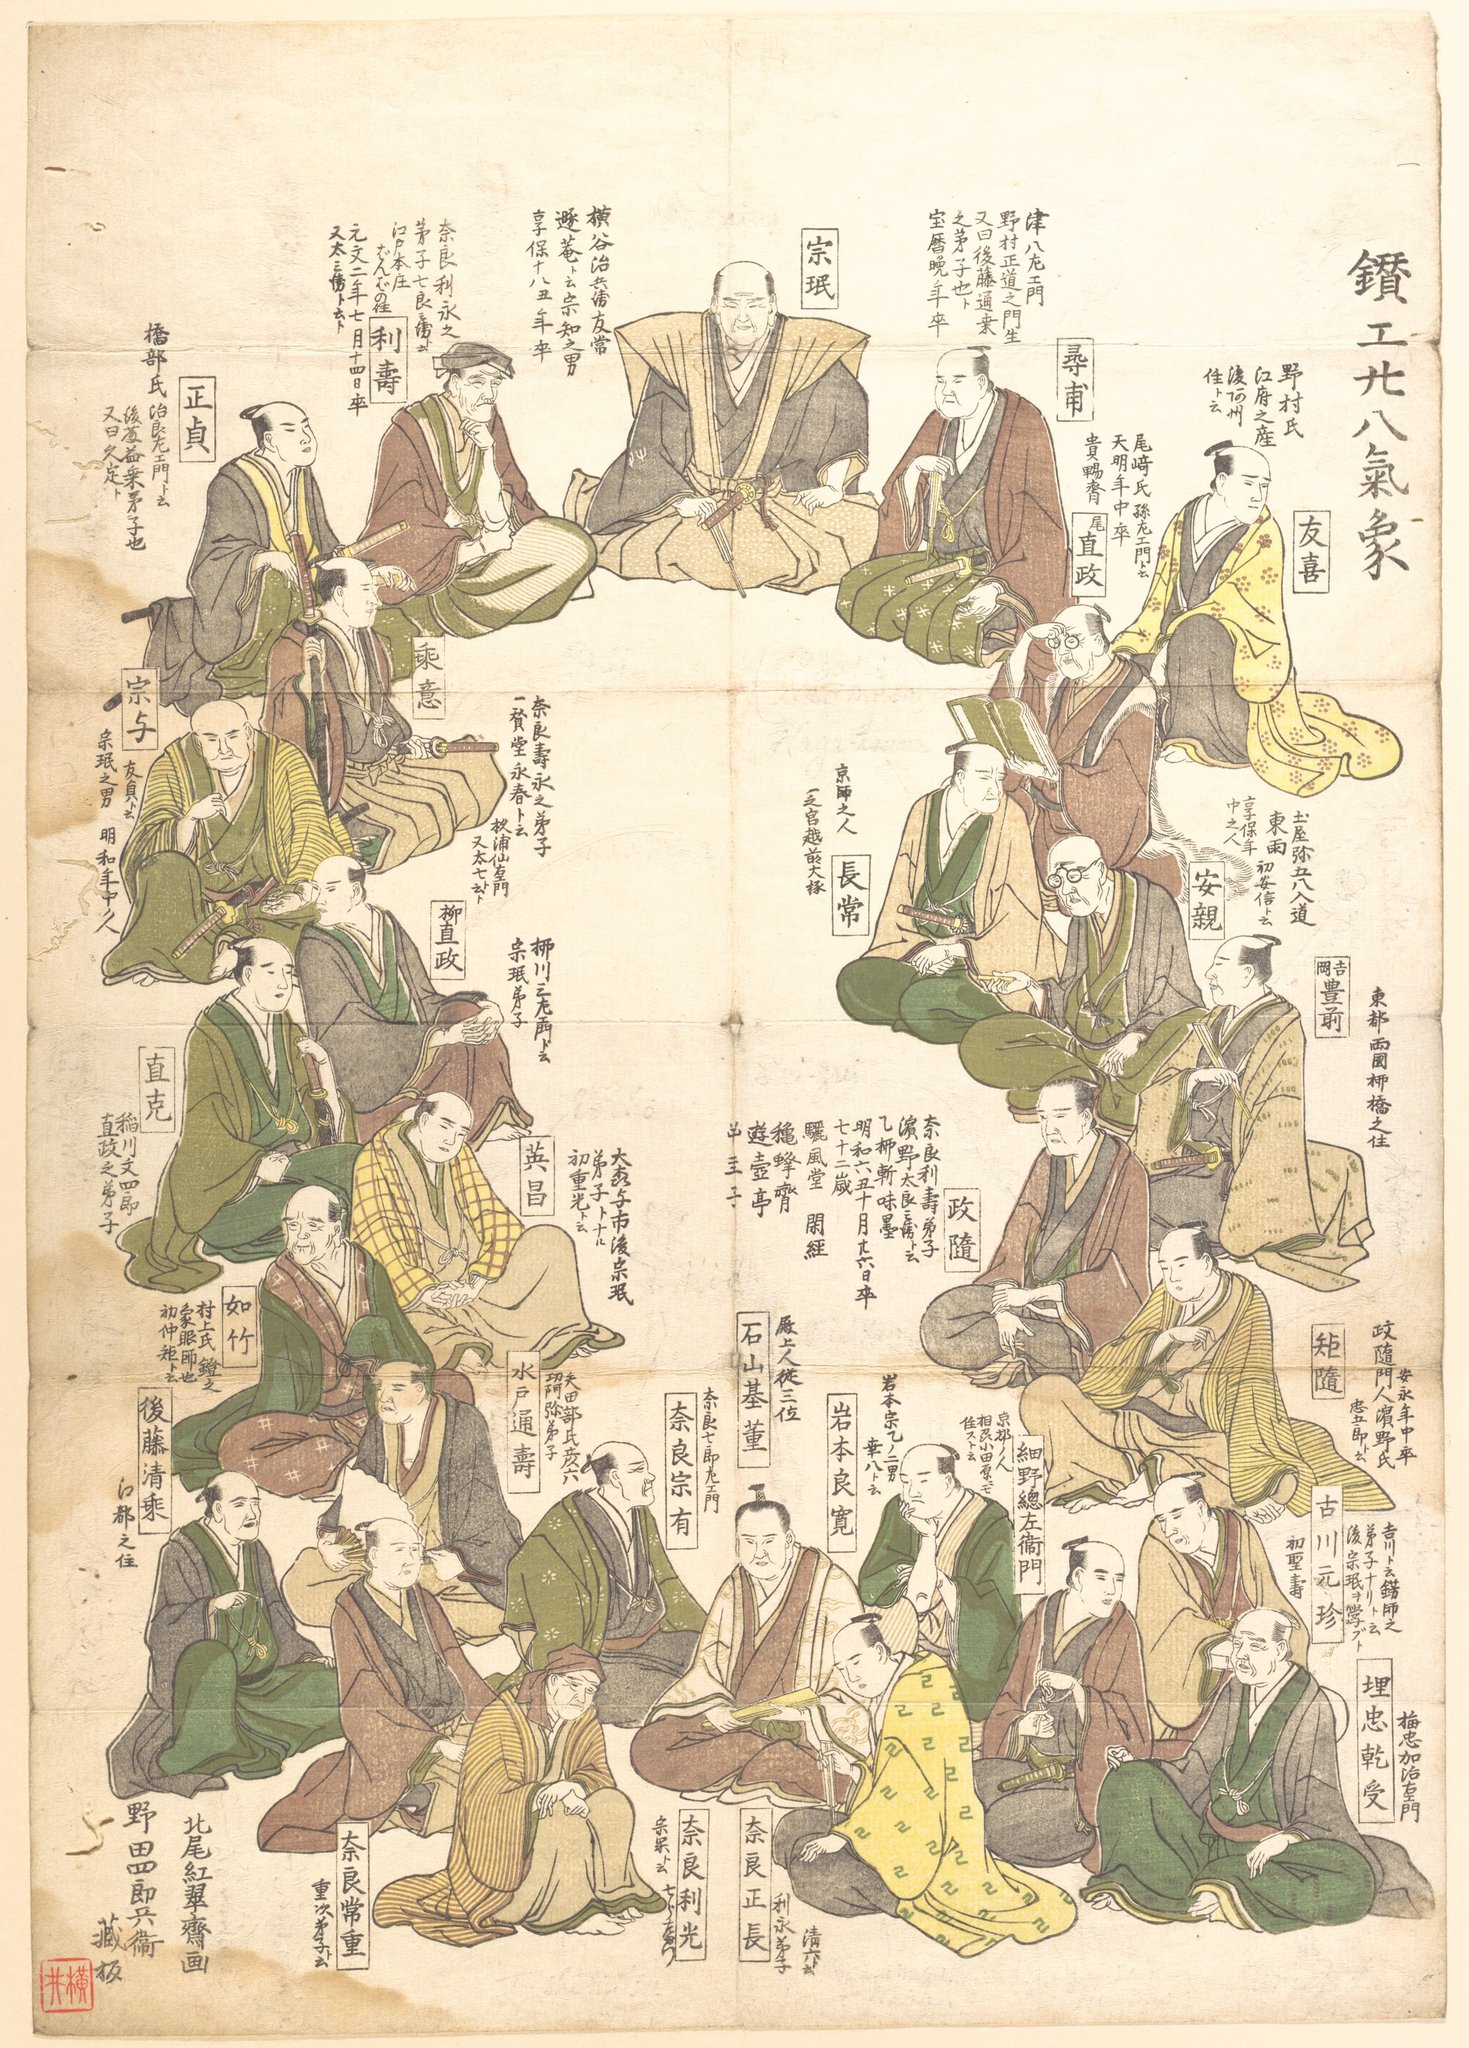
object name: print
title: Portraits of Twenty-eight Metal Artists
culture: japanese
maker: kitao shigemasa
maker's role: artist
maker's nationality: japanese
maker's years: 1739-1820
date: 1739-1820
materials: ink, paper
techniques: woodblock print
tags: men,artists